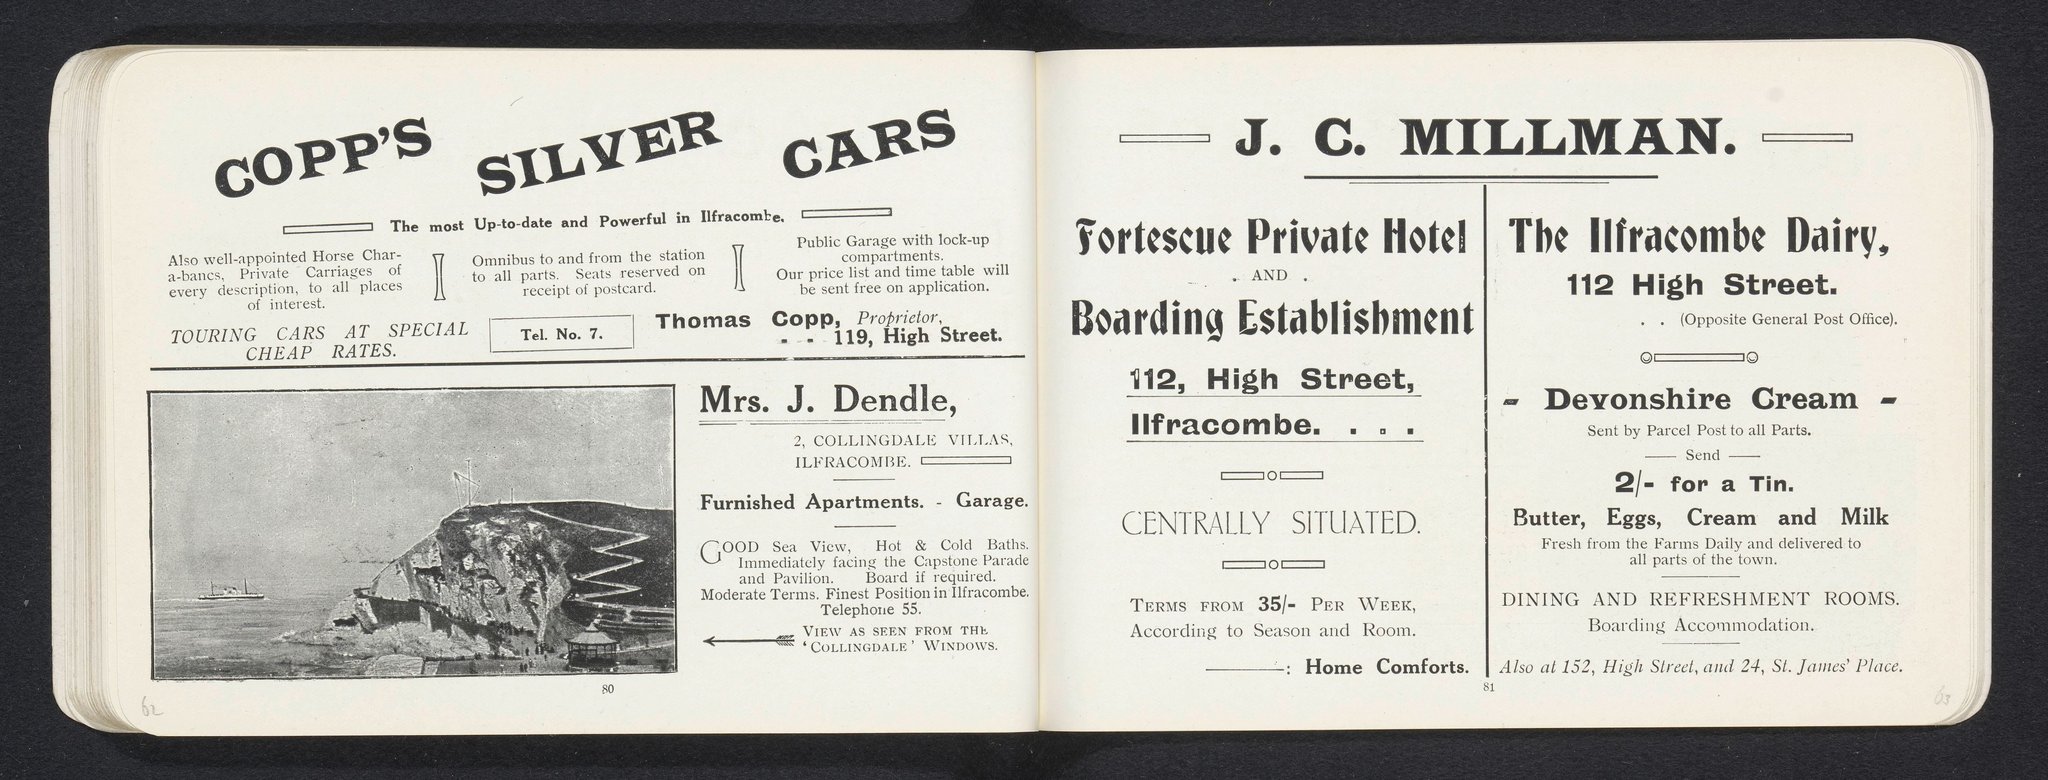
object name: page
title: Gezicht op Capstone Hill te Ilfracombe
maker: Anonymous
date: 1900-1920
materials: paper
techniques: autotype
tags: (high) hill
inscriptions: inscription: ‘Copp's silver cars (...) view from 'Collingdale' windows.’